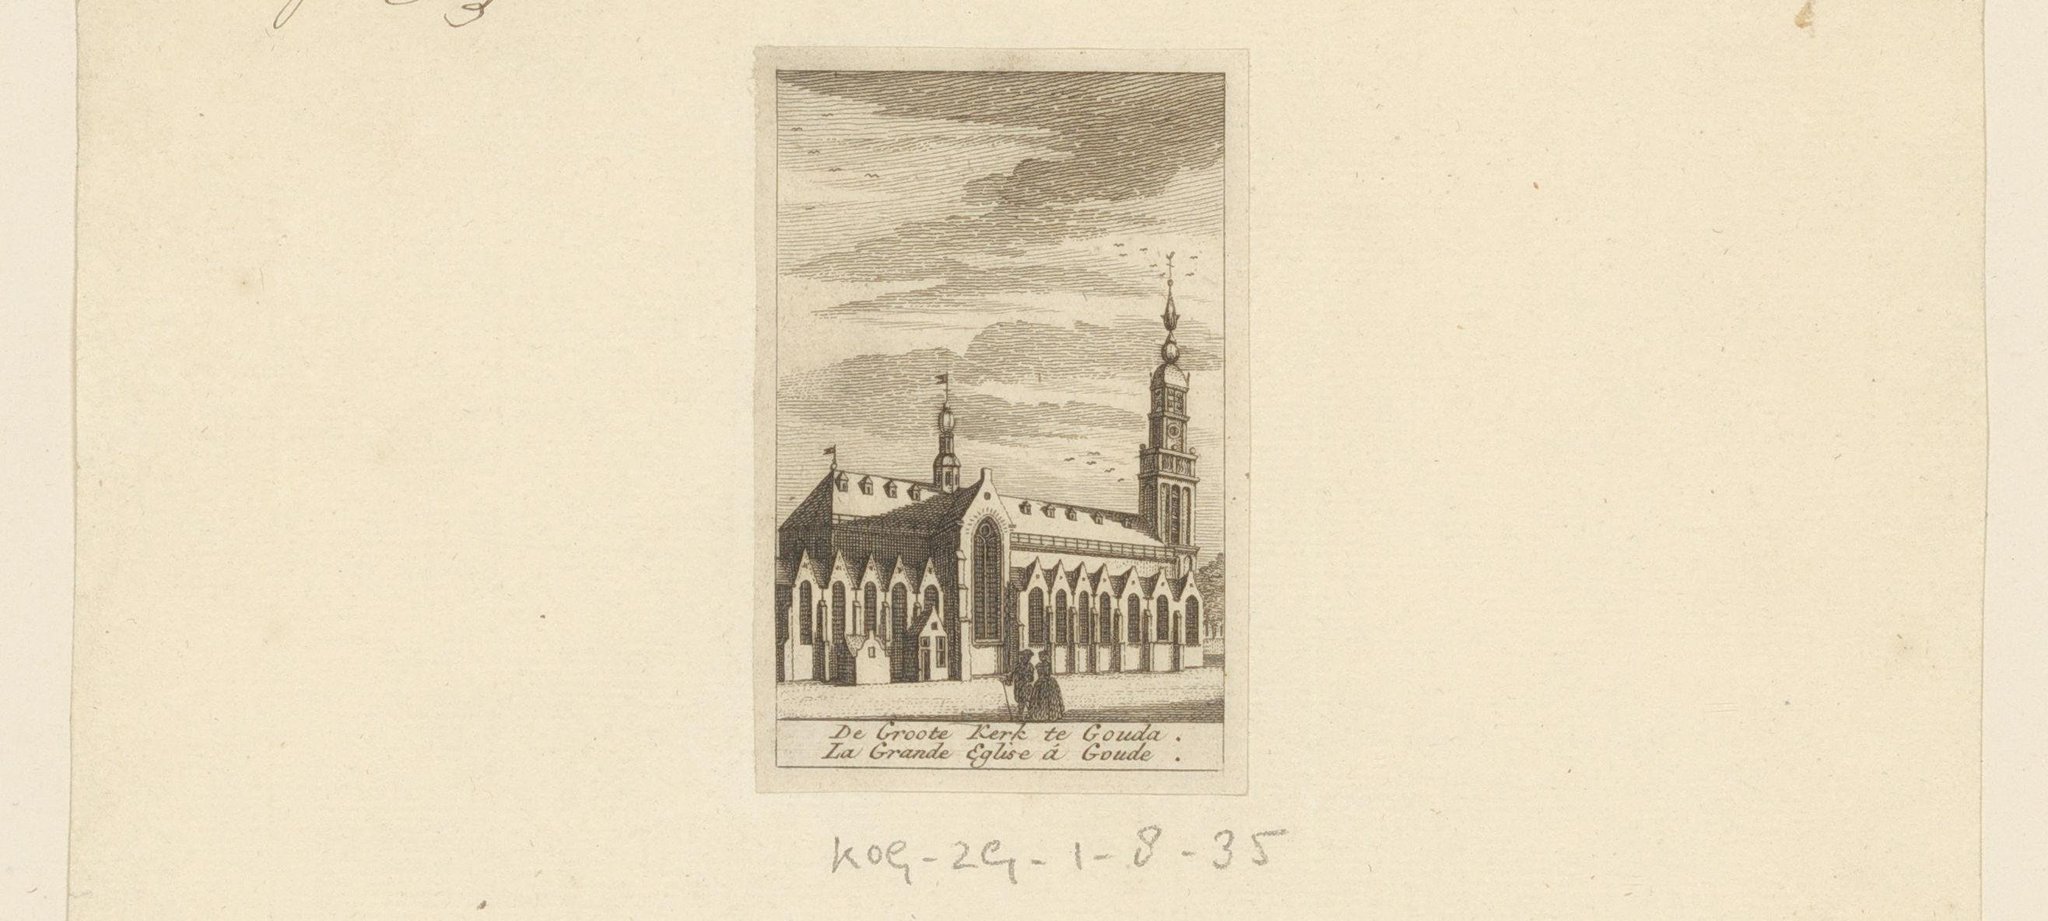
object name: print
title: De Groote Kerk te Gouda / La Grande Eglise á Goude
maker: Anonymous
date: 1700-1799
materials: paper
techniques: engraving, etching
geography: netherlands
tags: church (exterior)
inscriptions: collector's mark, collector's mark: Lugt 1641, inscription: ‘JdeClercq 1857 No. 260’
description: Gezicht op de Sint-Janskerk te Gouda. Onderwerpsrubrieken binnen de Atlas Zeden en Gewoonten: Kerk en kerkwezen & Armwezen en liefdadige instellingen; Kerkgebouwen elders. F-L.